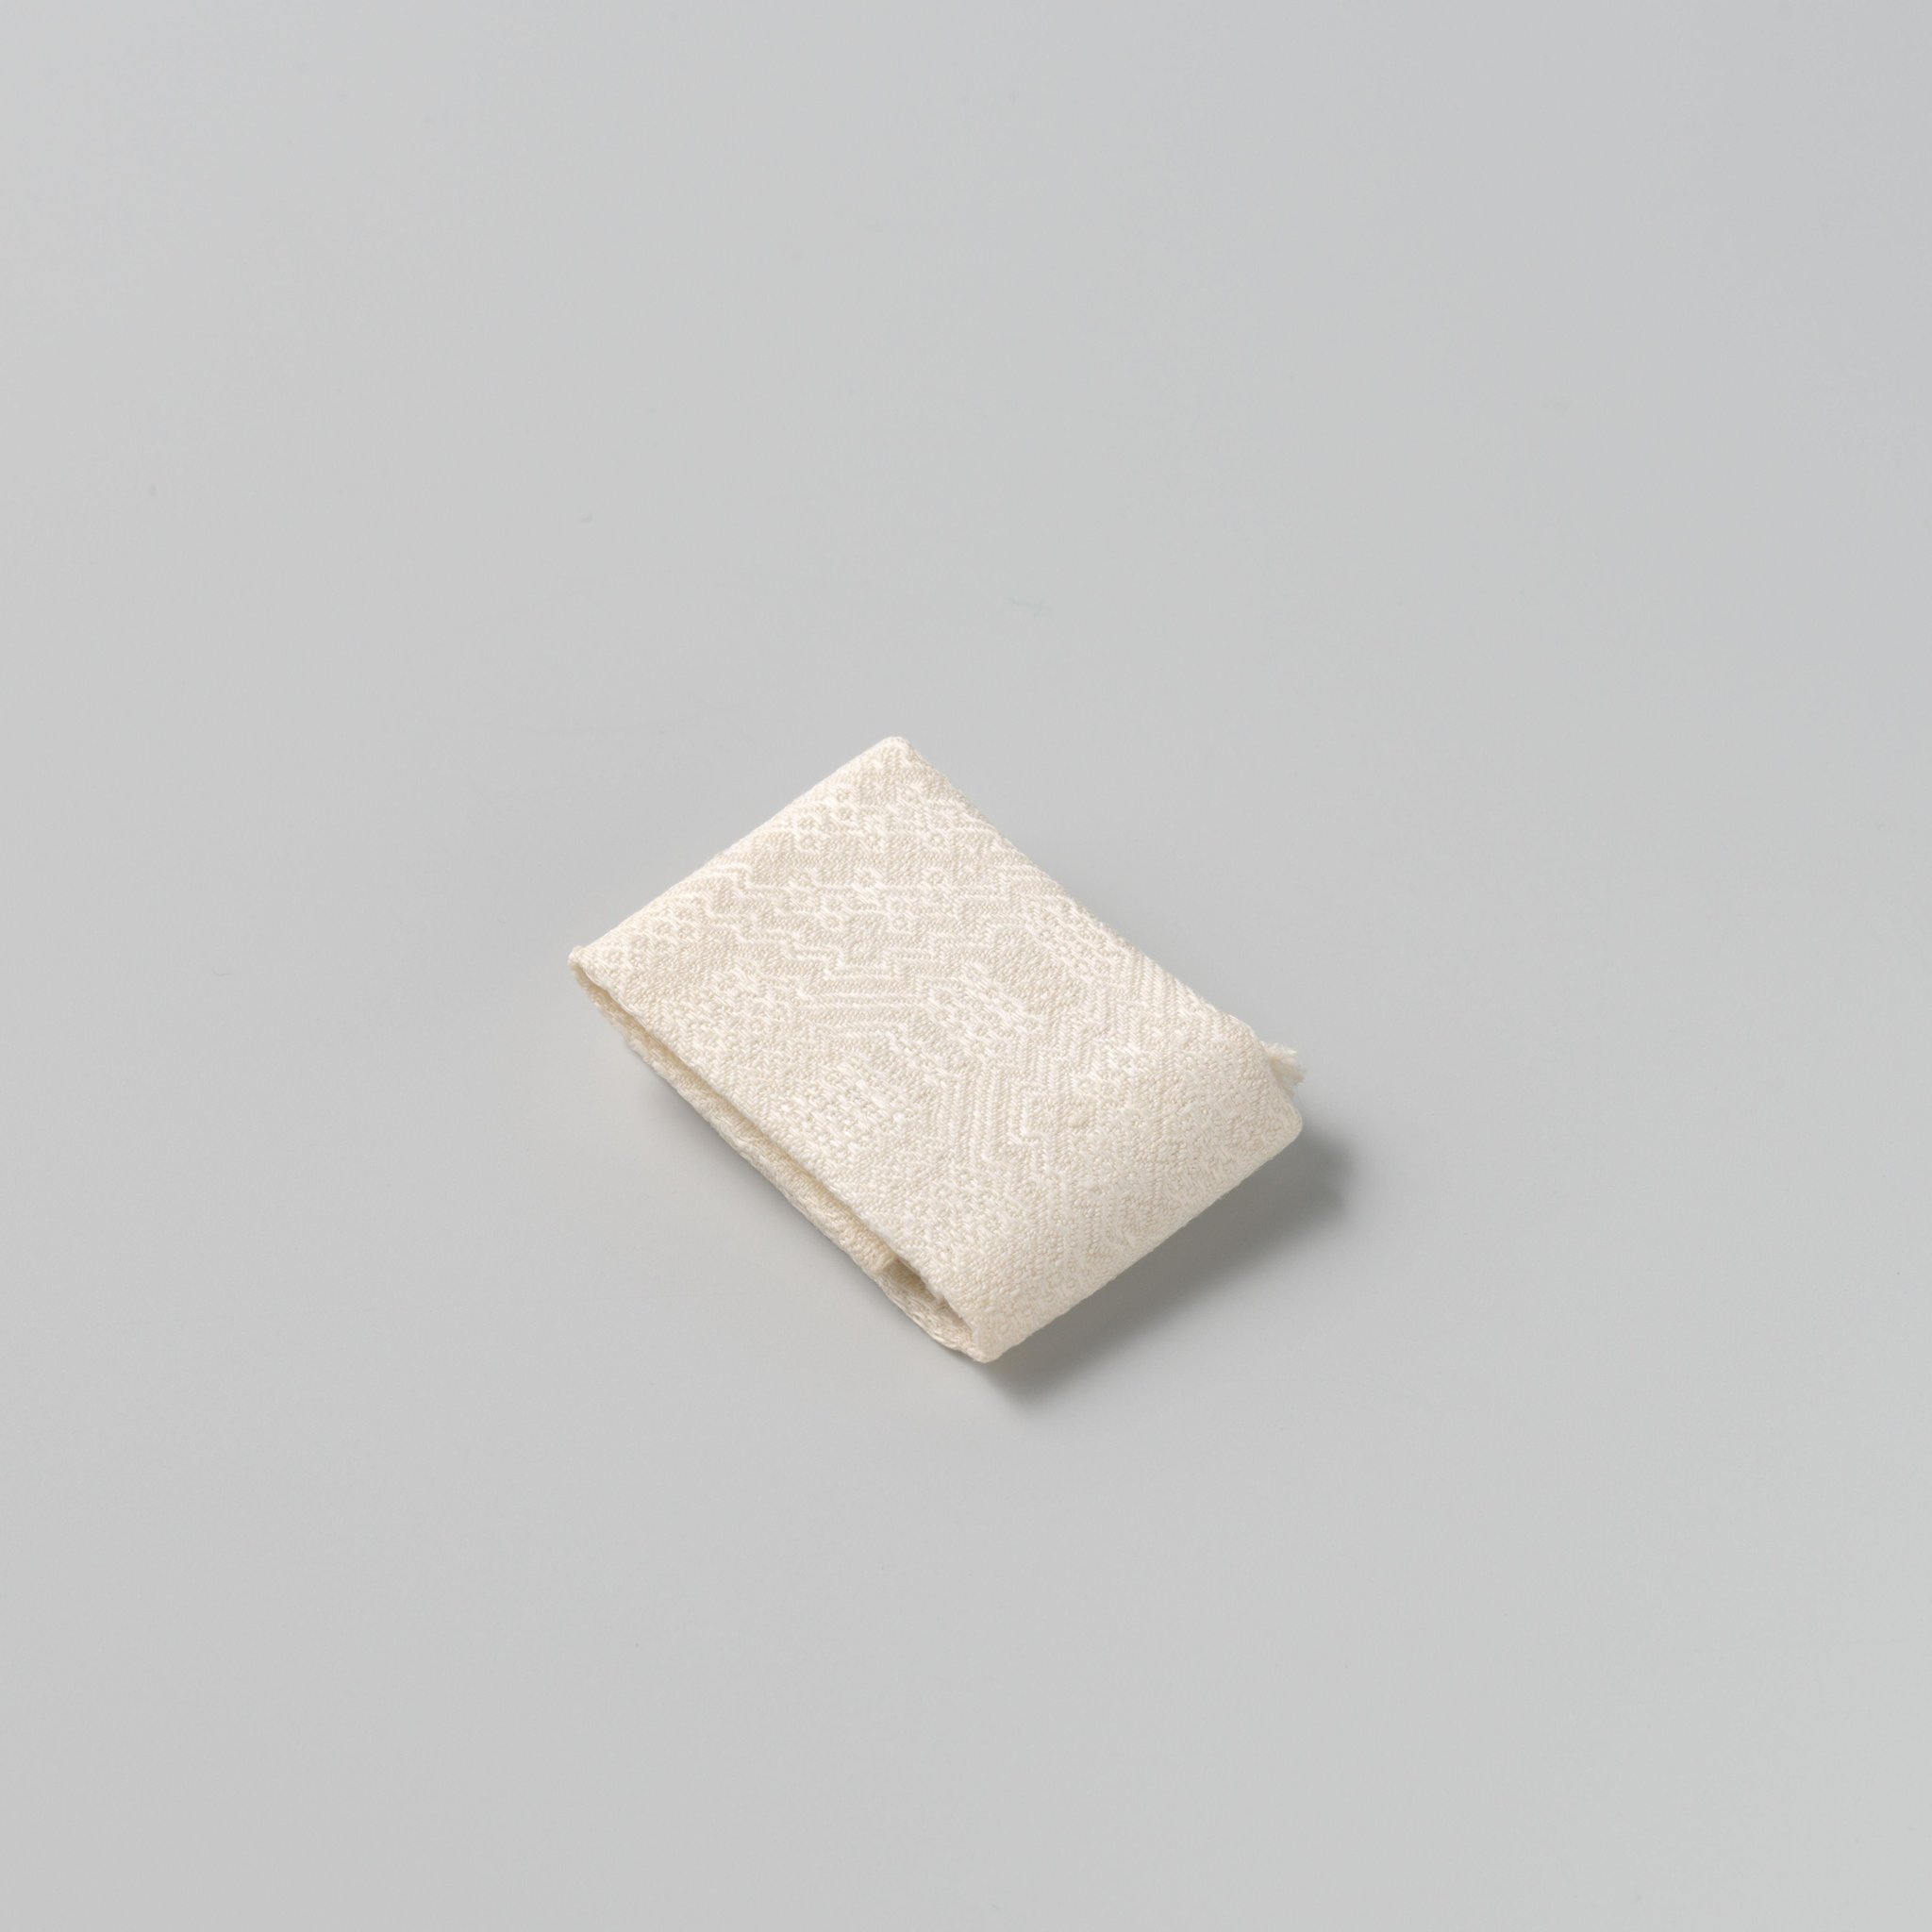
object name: napkin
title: Servet, damastweefsel met een pellenpatroon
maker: Anonymous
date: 1600-1699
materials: linen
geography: netherlands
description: Servet, damastweefsel met pellenpatroon, geknipt uit een groter stuk linnen, niet omgezoomd.